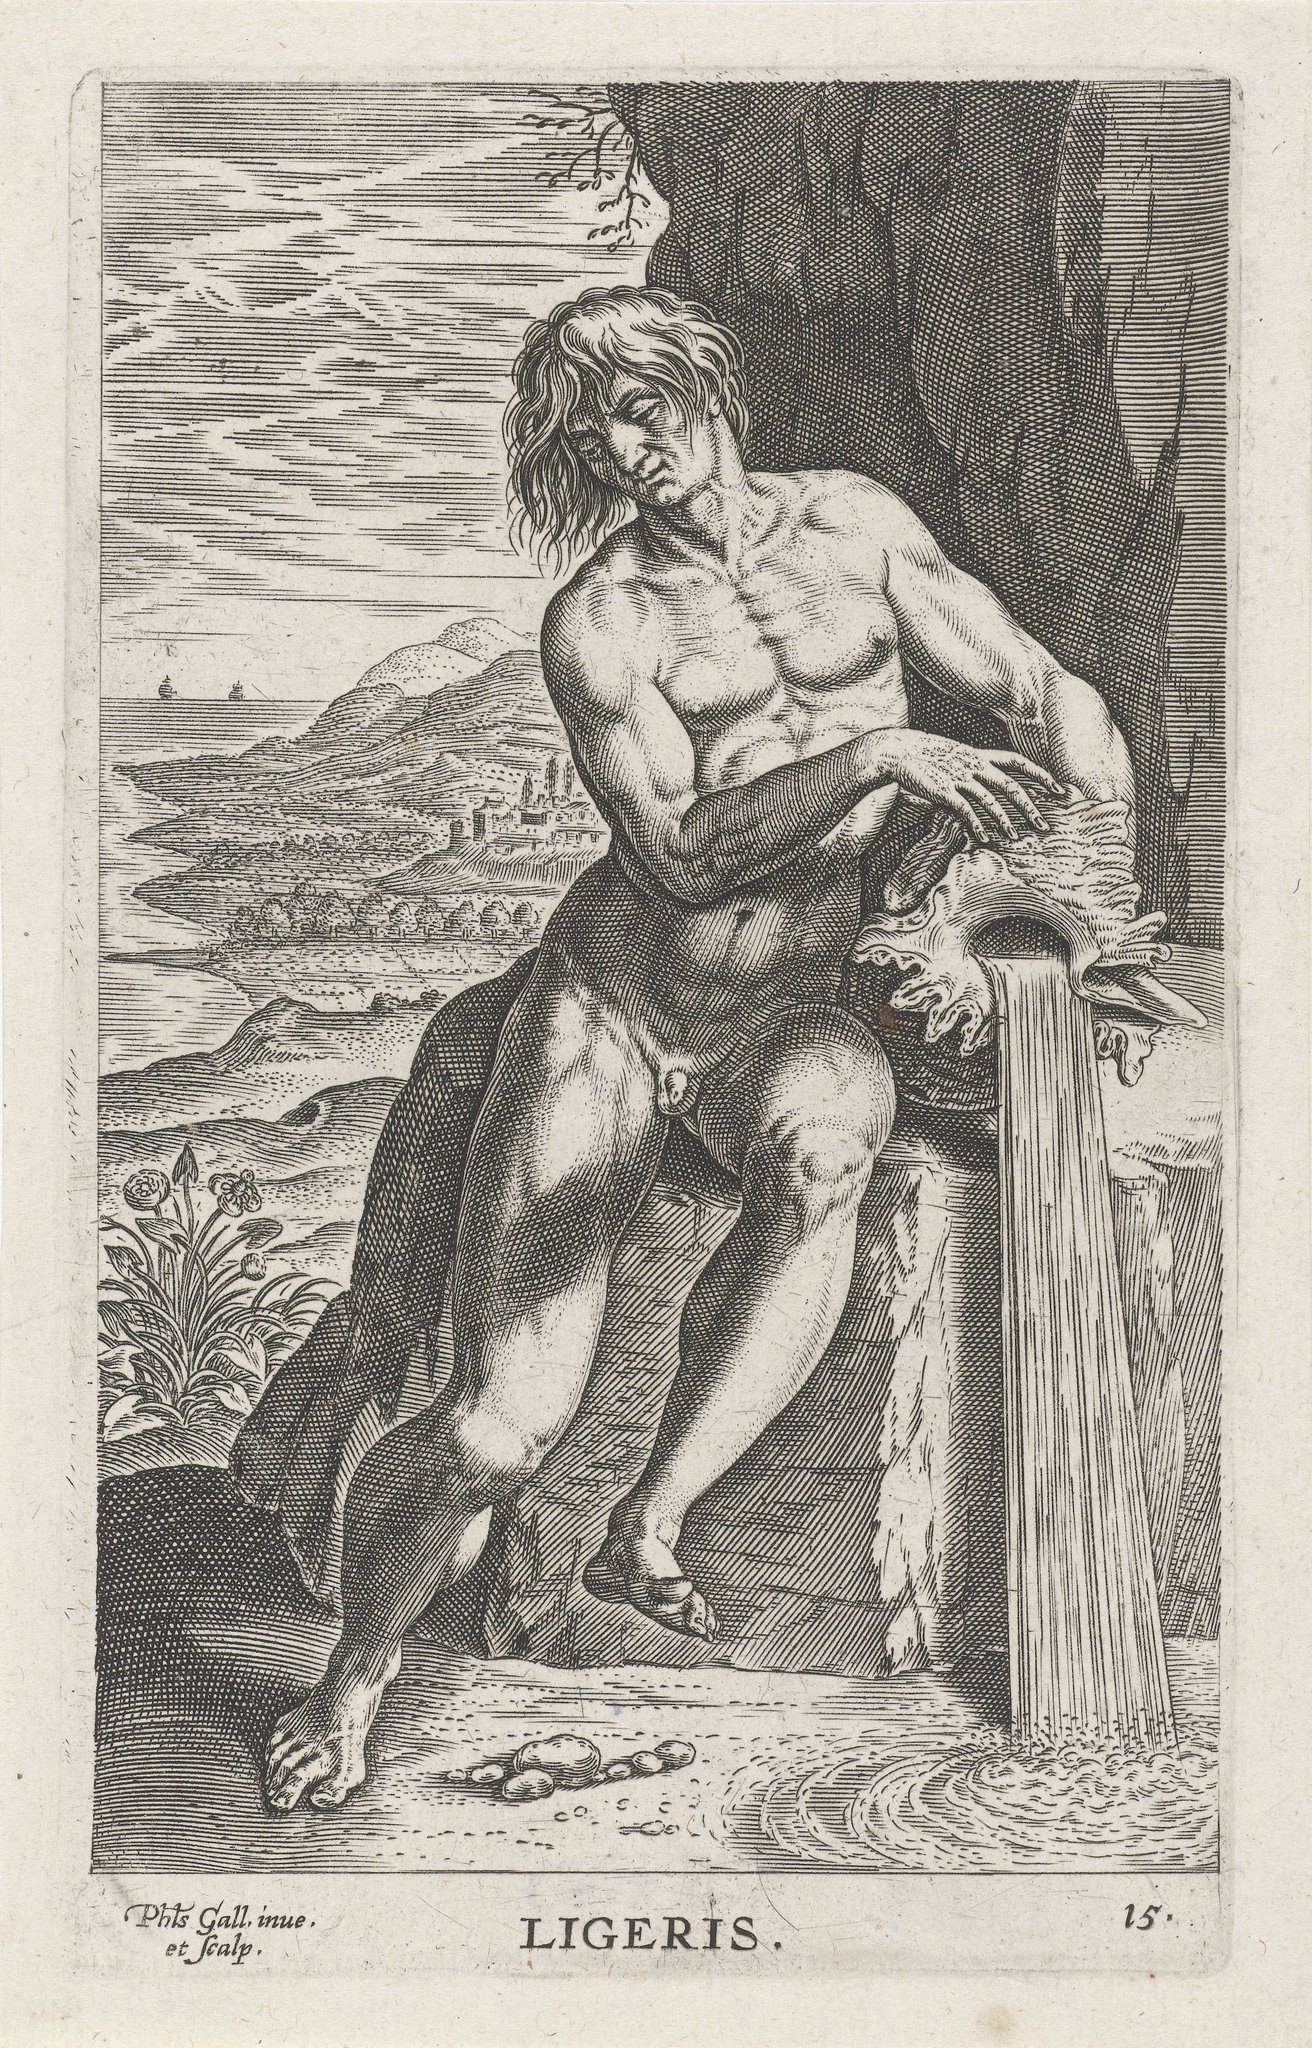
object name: print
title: Riviergod Ligeris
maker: philips galle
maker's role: print maker, publisher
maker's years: 1537-1612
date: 1586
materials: paper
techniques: engraving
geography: antwerp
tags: river personified, 'fiumi' (ripa)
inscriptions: collector's mark: Lugt 2228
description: De riviergod Ligeris (de Loire), gezeten op een stenen blok. In zijn hand een schelp. De prent maakt deel uit van een zeventiendelige serie over rivier- en zeegoden.